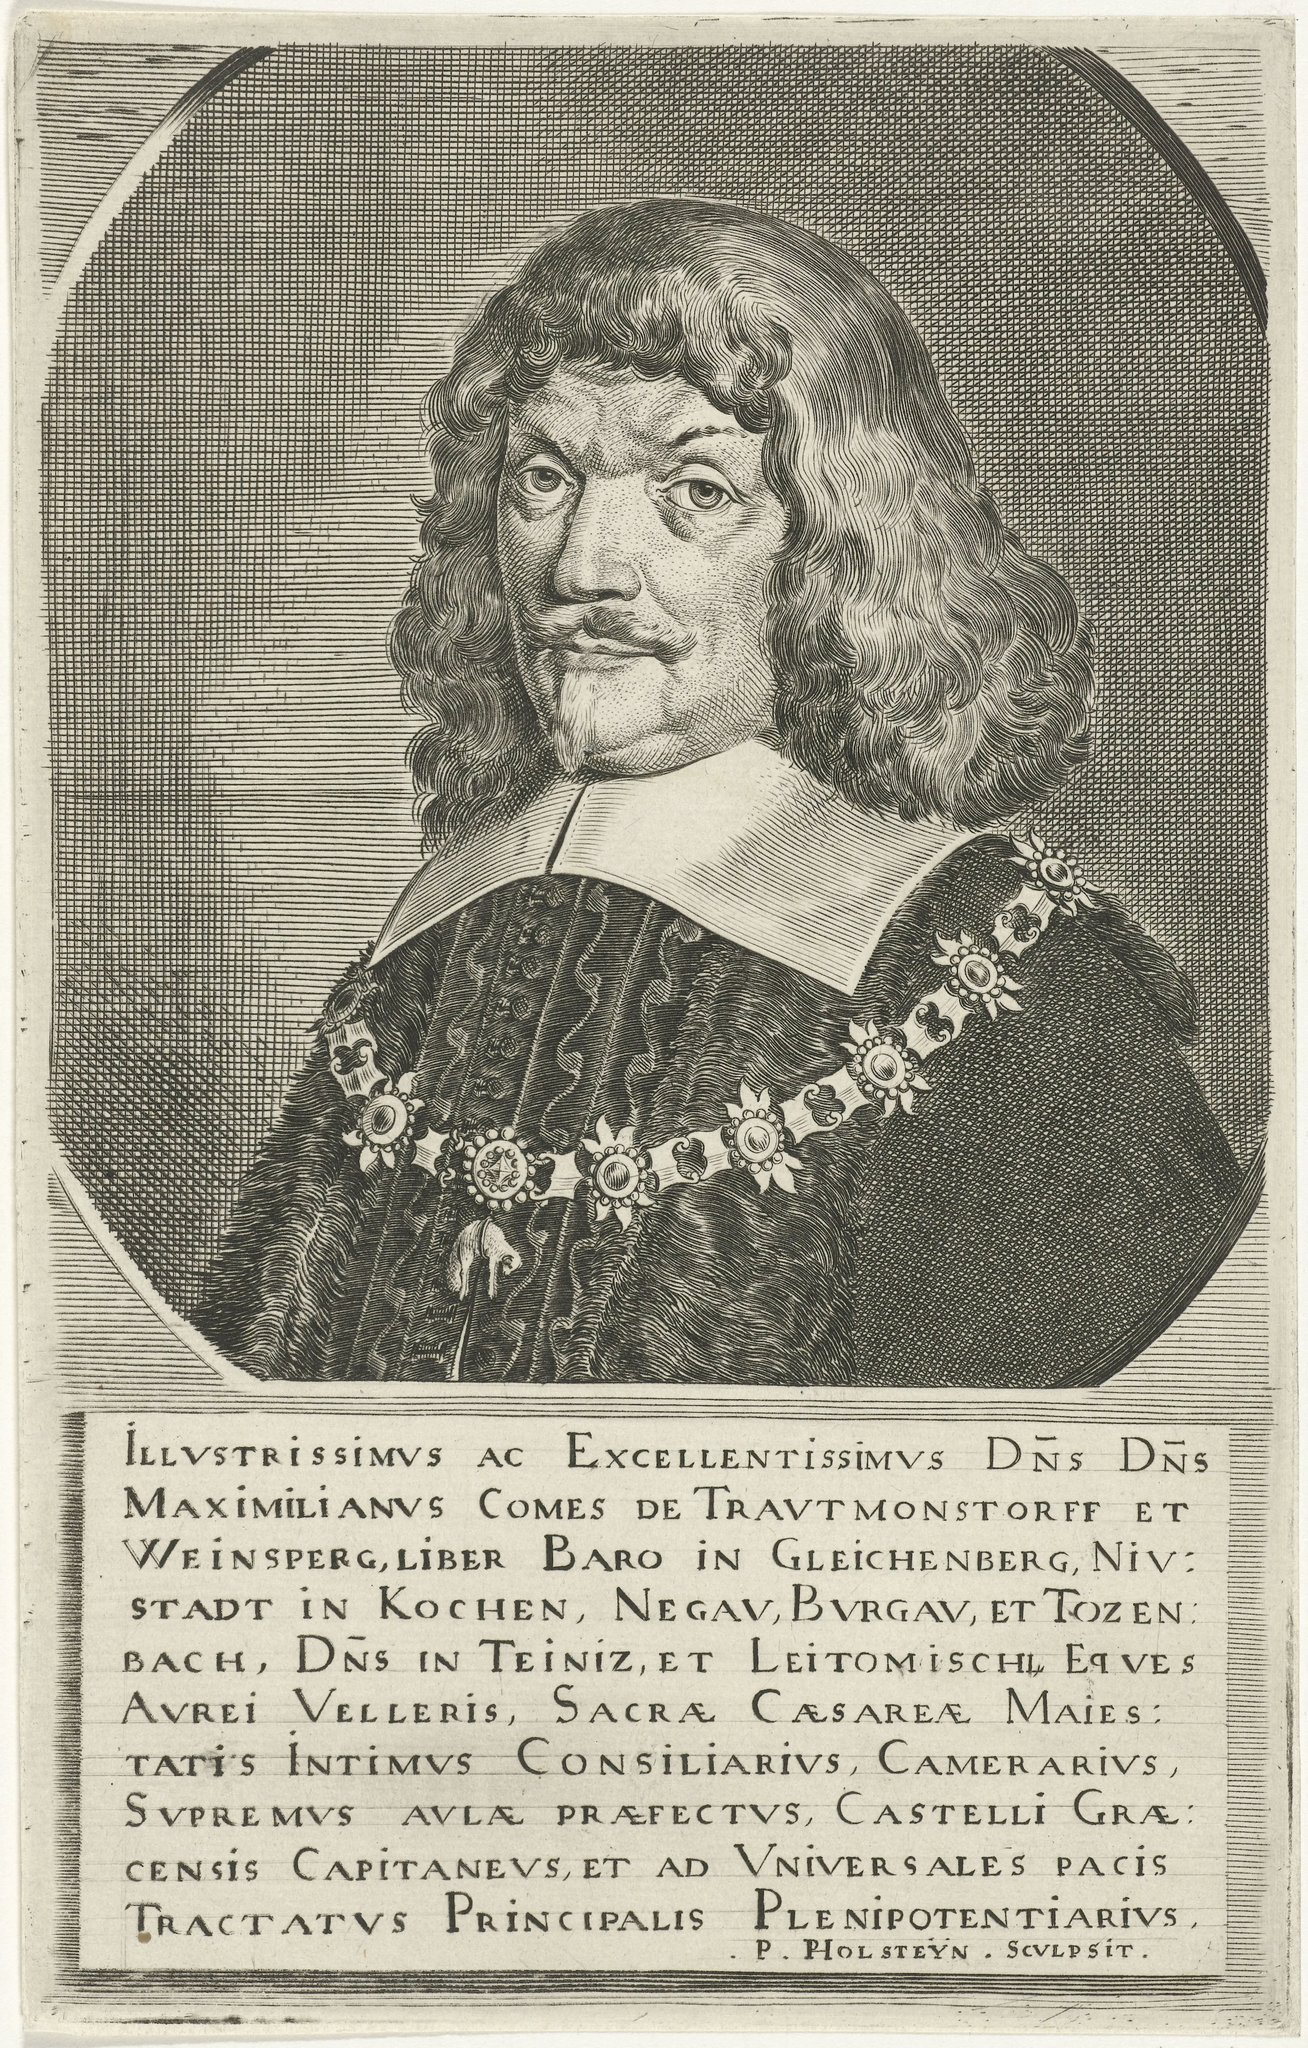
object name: print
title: Portretten van ambassadeurs van de Vrede van Munster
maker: pieter holsteyn (ii)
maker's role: draughtsman, print maker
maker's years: 1614-1673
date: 1648-1670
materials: paper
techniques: engraving, etching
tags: earl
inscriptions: collector's mark: Lugt 2228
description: Buste naar links van Maximiliaan, graaf van Trauttmansdorff. Onder het portret tien regels in het Latijn. Prent uit een serie portretten van ambassadeurs betrokken bij het vredesverdrag van Munster.